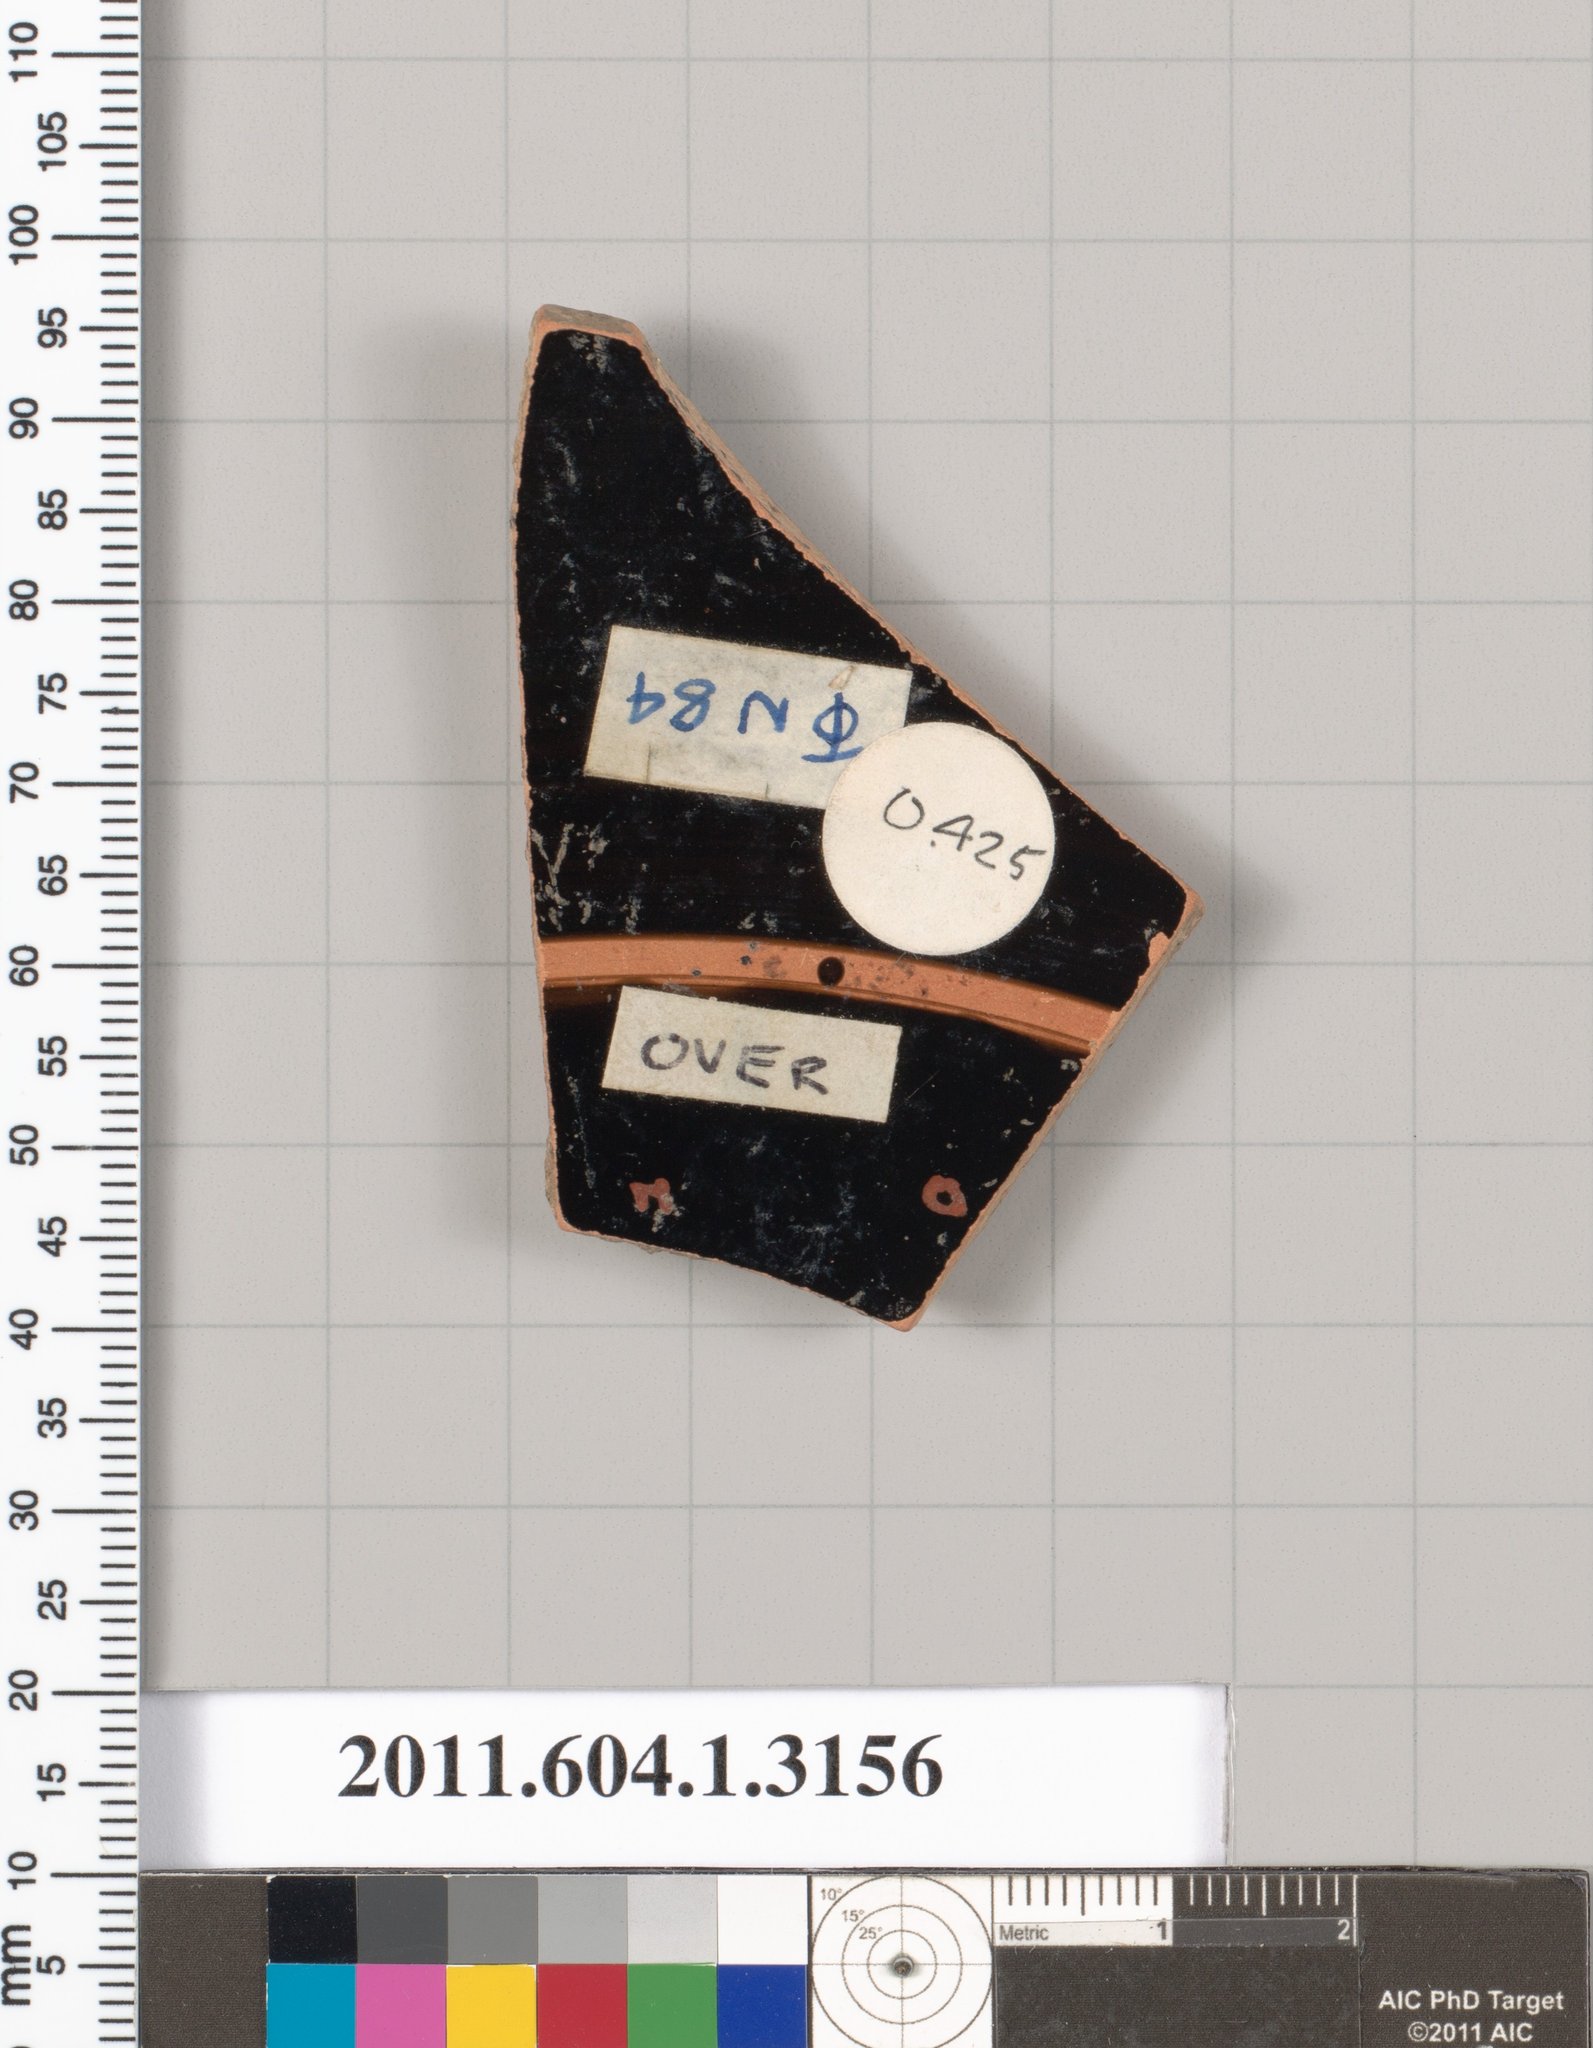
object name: kylix fragment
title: Terracotta fragment of a kylix (drinking cup)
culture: greek, attic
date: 500-490 BCE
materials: terracotta